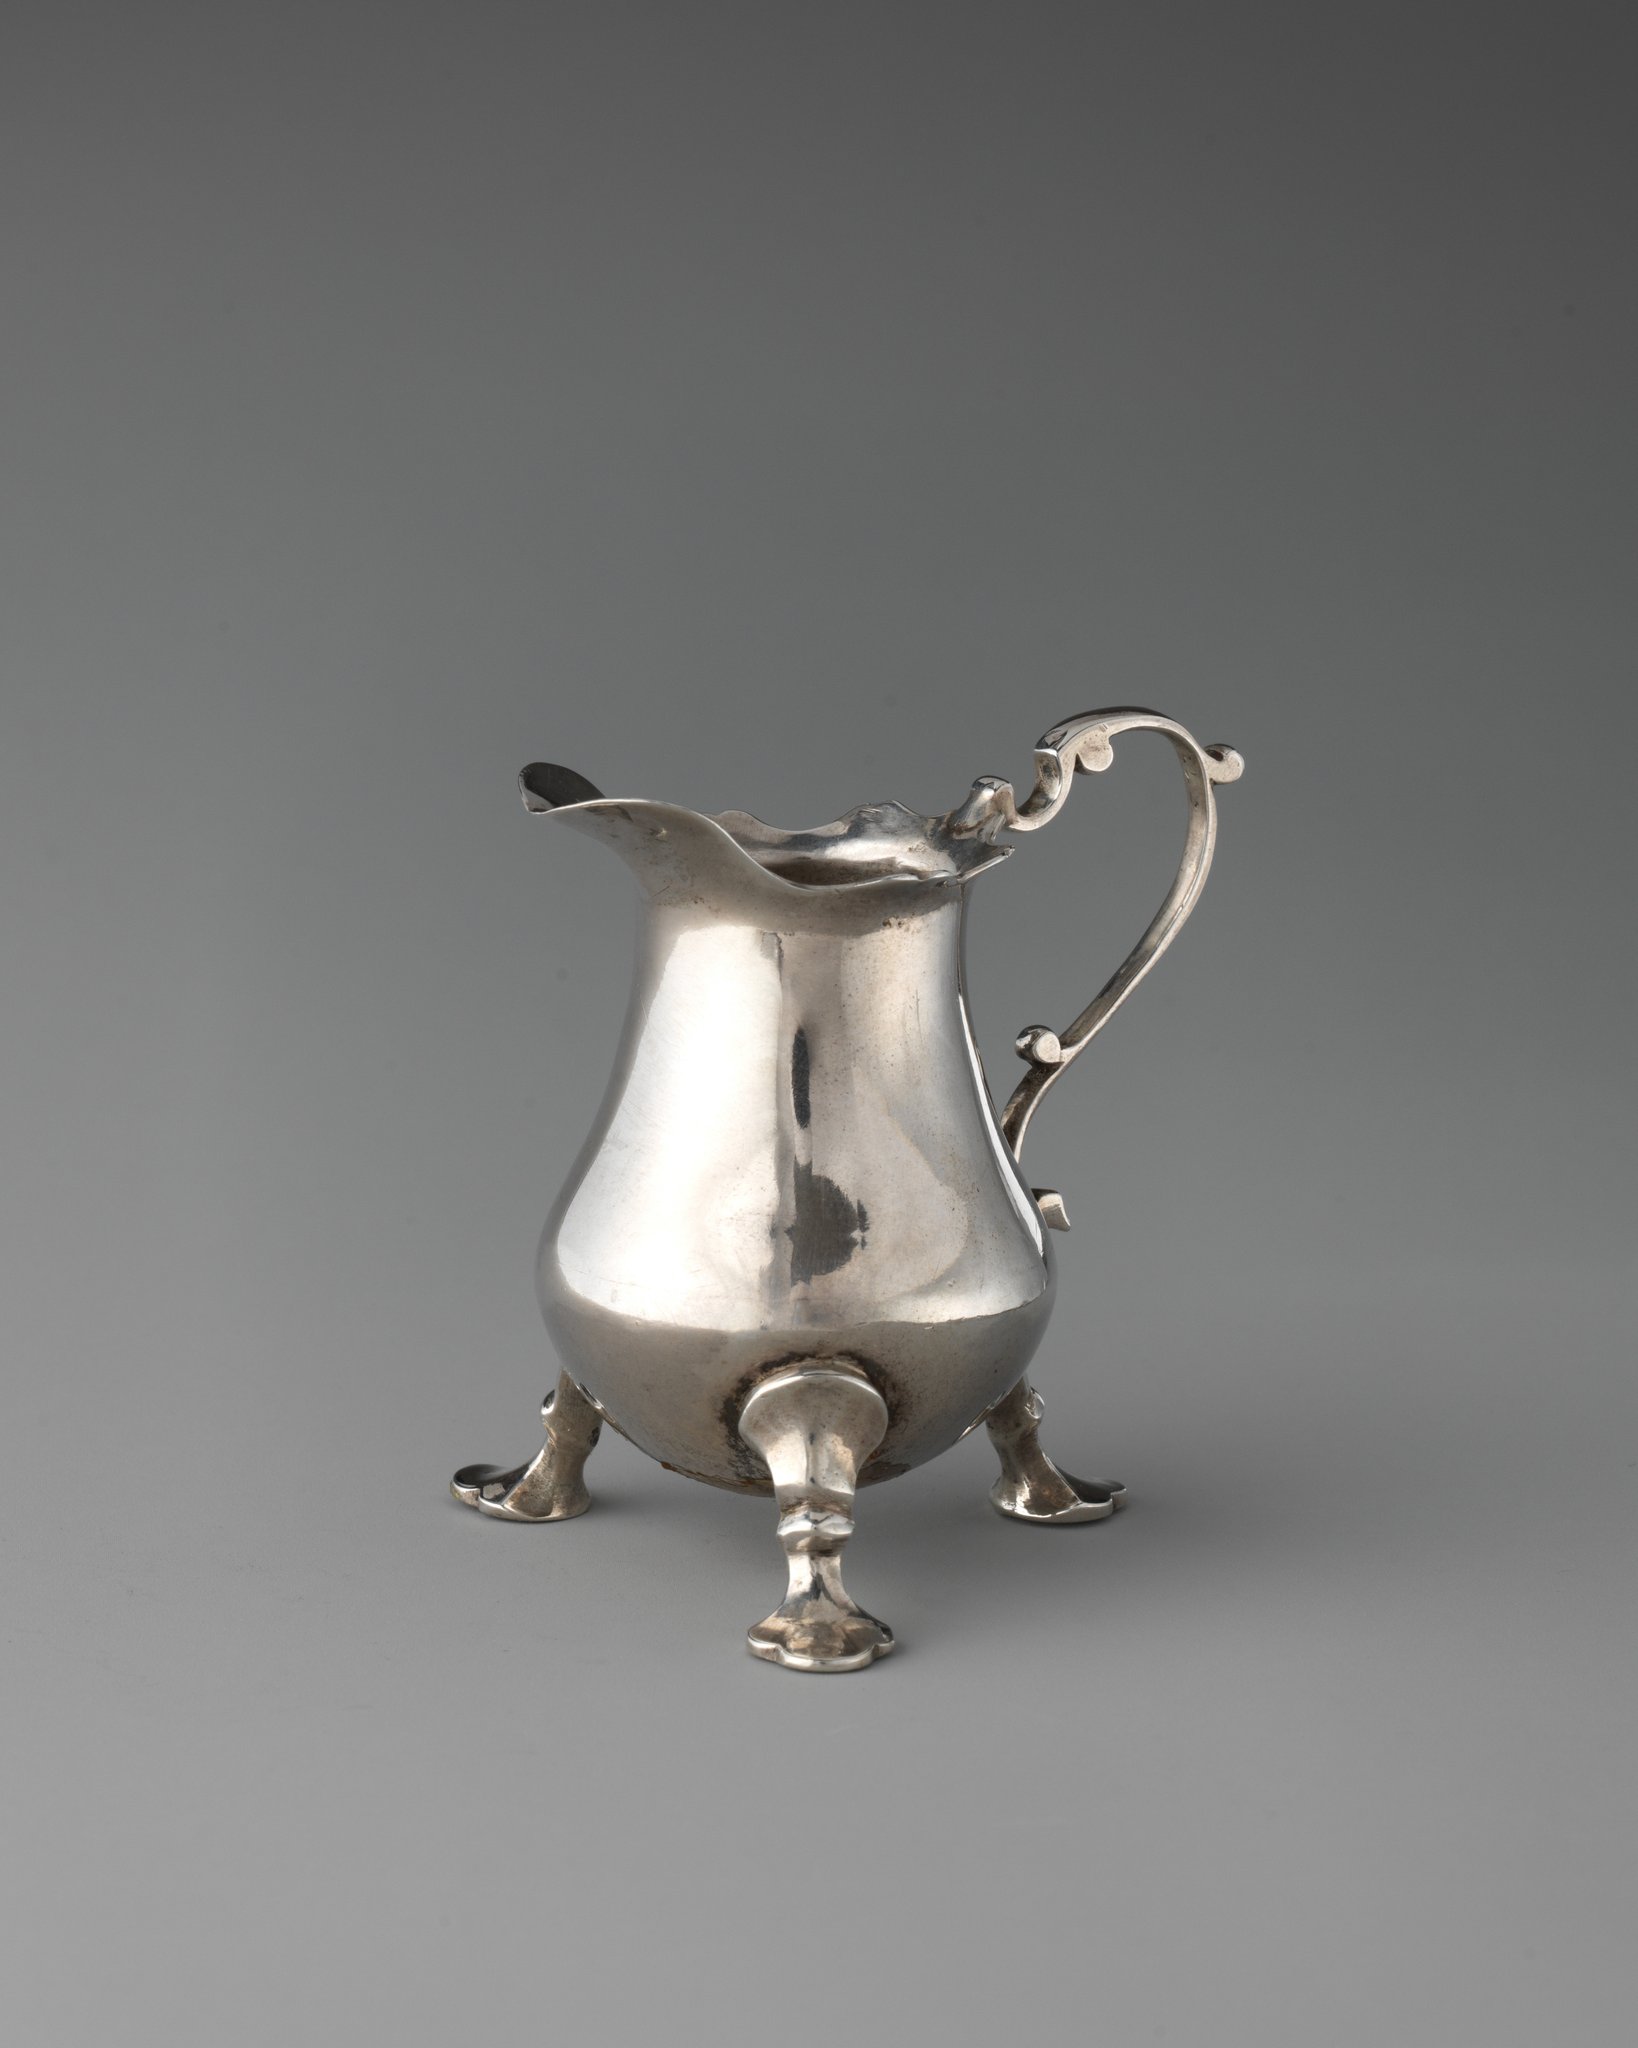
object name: cream jug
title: Miniature cream jug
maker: john le sage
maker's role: maker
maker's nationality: british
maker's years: 1718-1743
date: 1701-1800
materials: silver